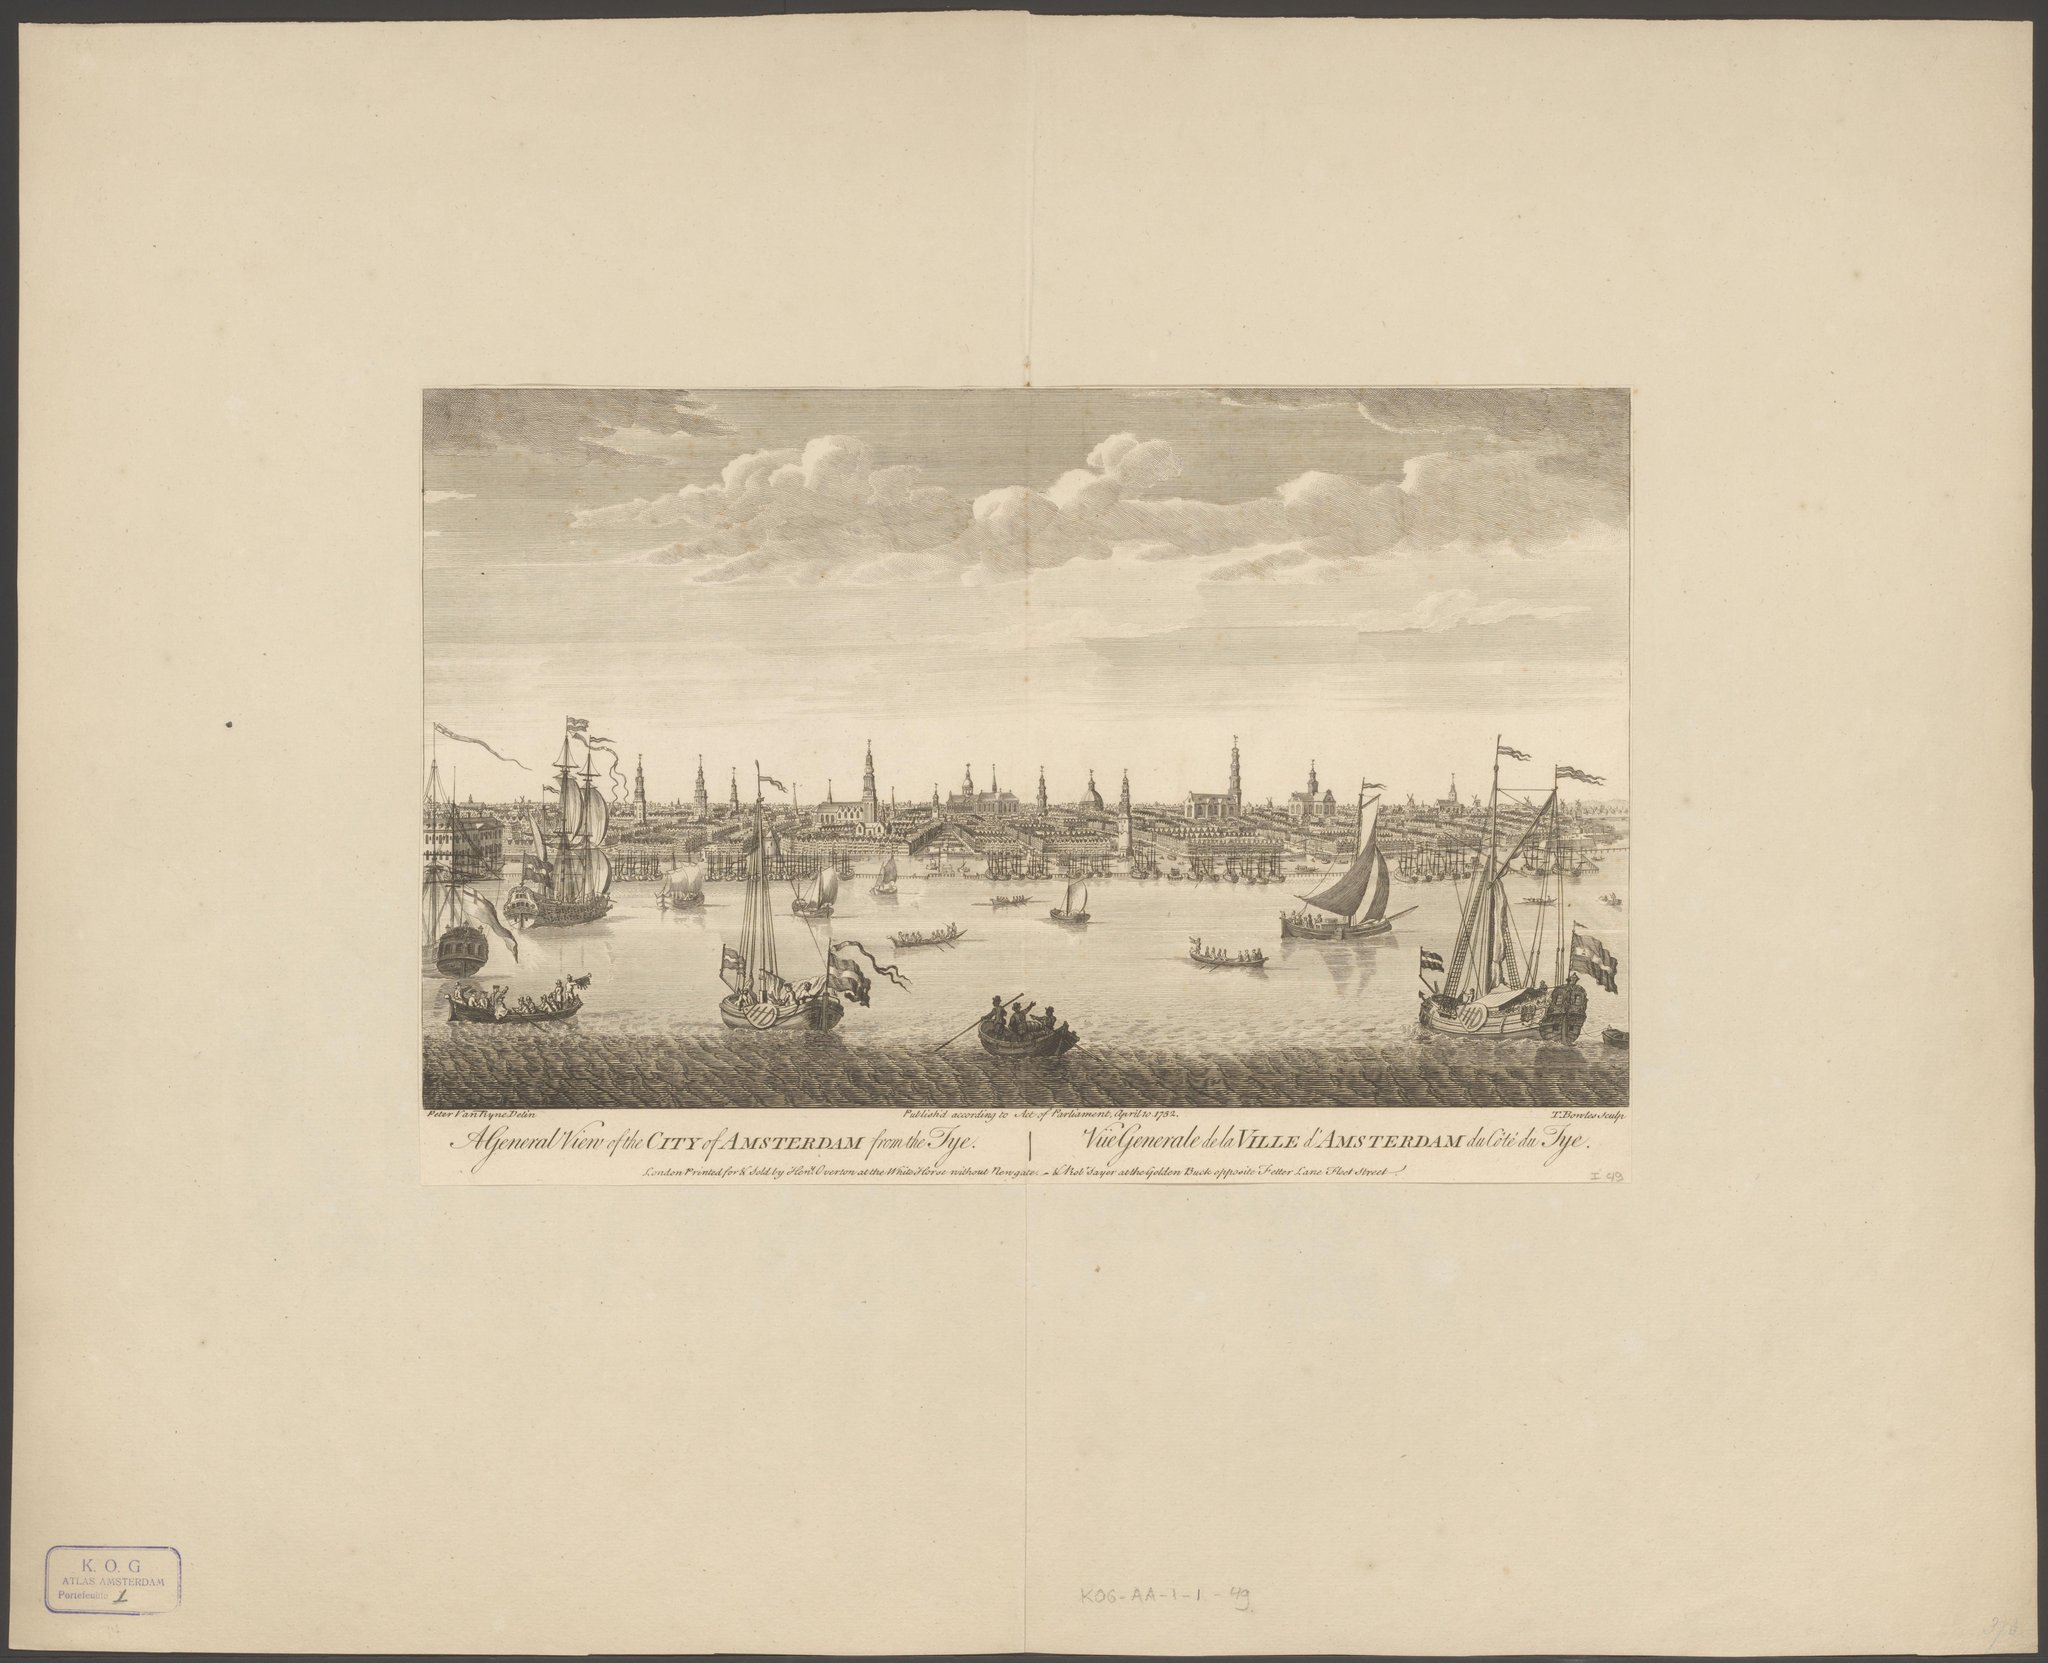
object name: print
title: Gezicht op de stad Amsterdam vanaf het IJ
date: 1752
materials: paper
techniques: etching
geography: london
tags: city-view in general; 'veduta', river, ships (in general) - cc - more than one ship, amsterdam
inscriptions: collector's mark: ‘1’ Lugt 1641b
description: Onderwerpsrubriek binnen de Atlas Amsterdam: Gezichten van den geheelen IJkant der Stad.